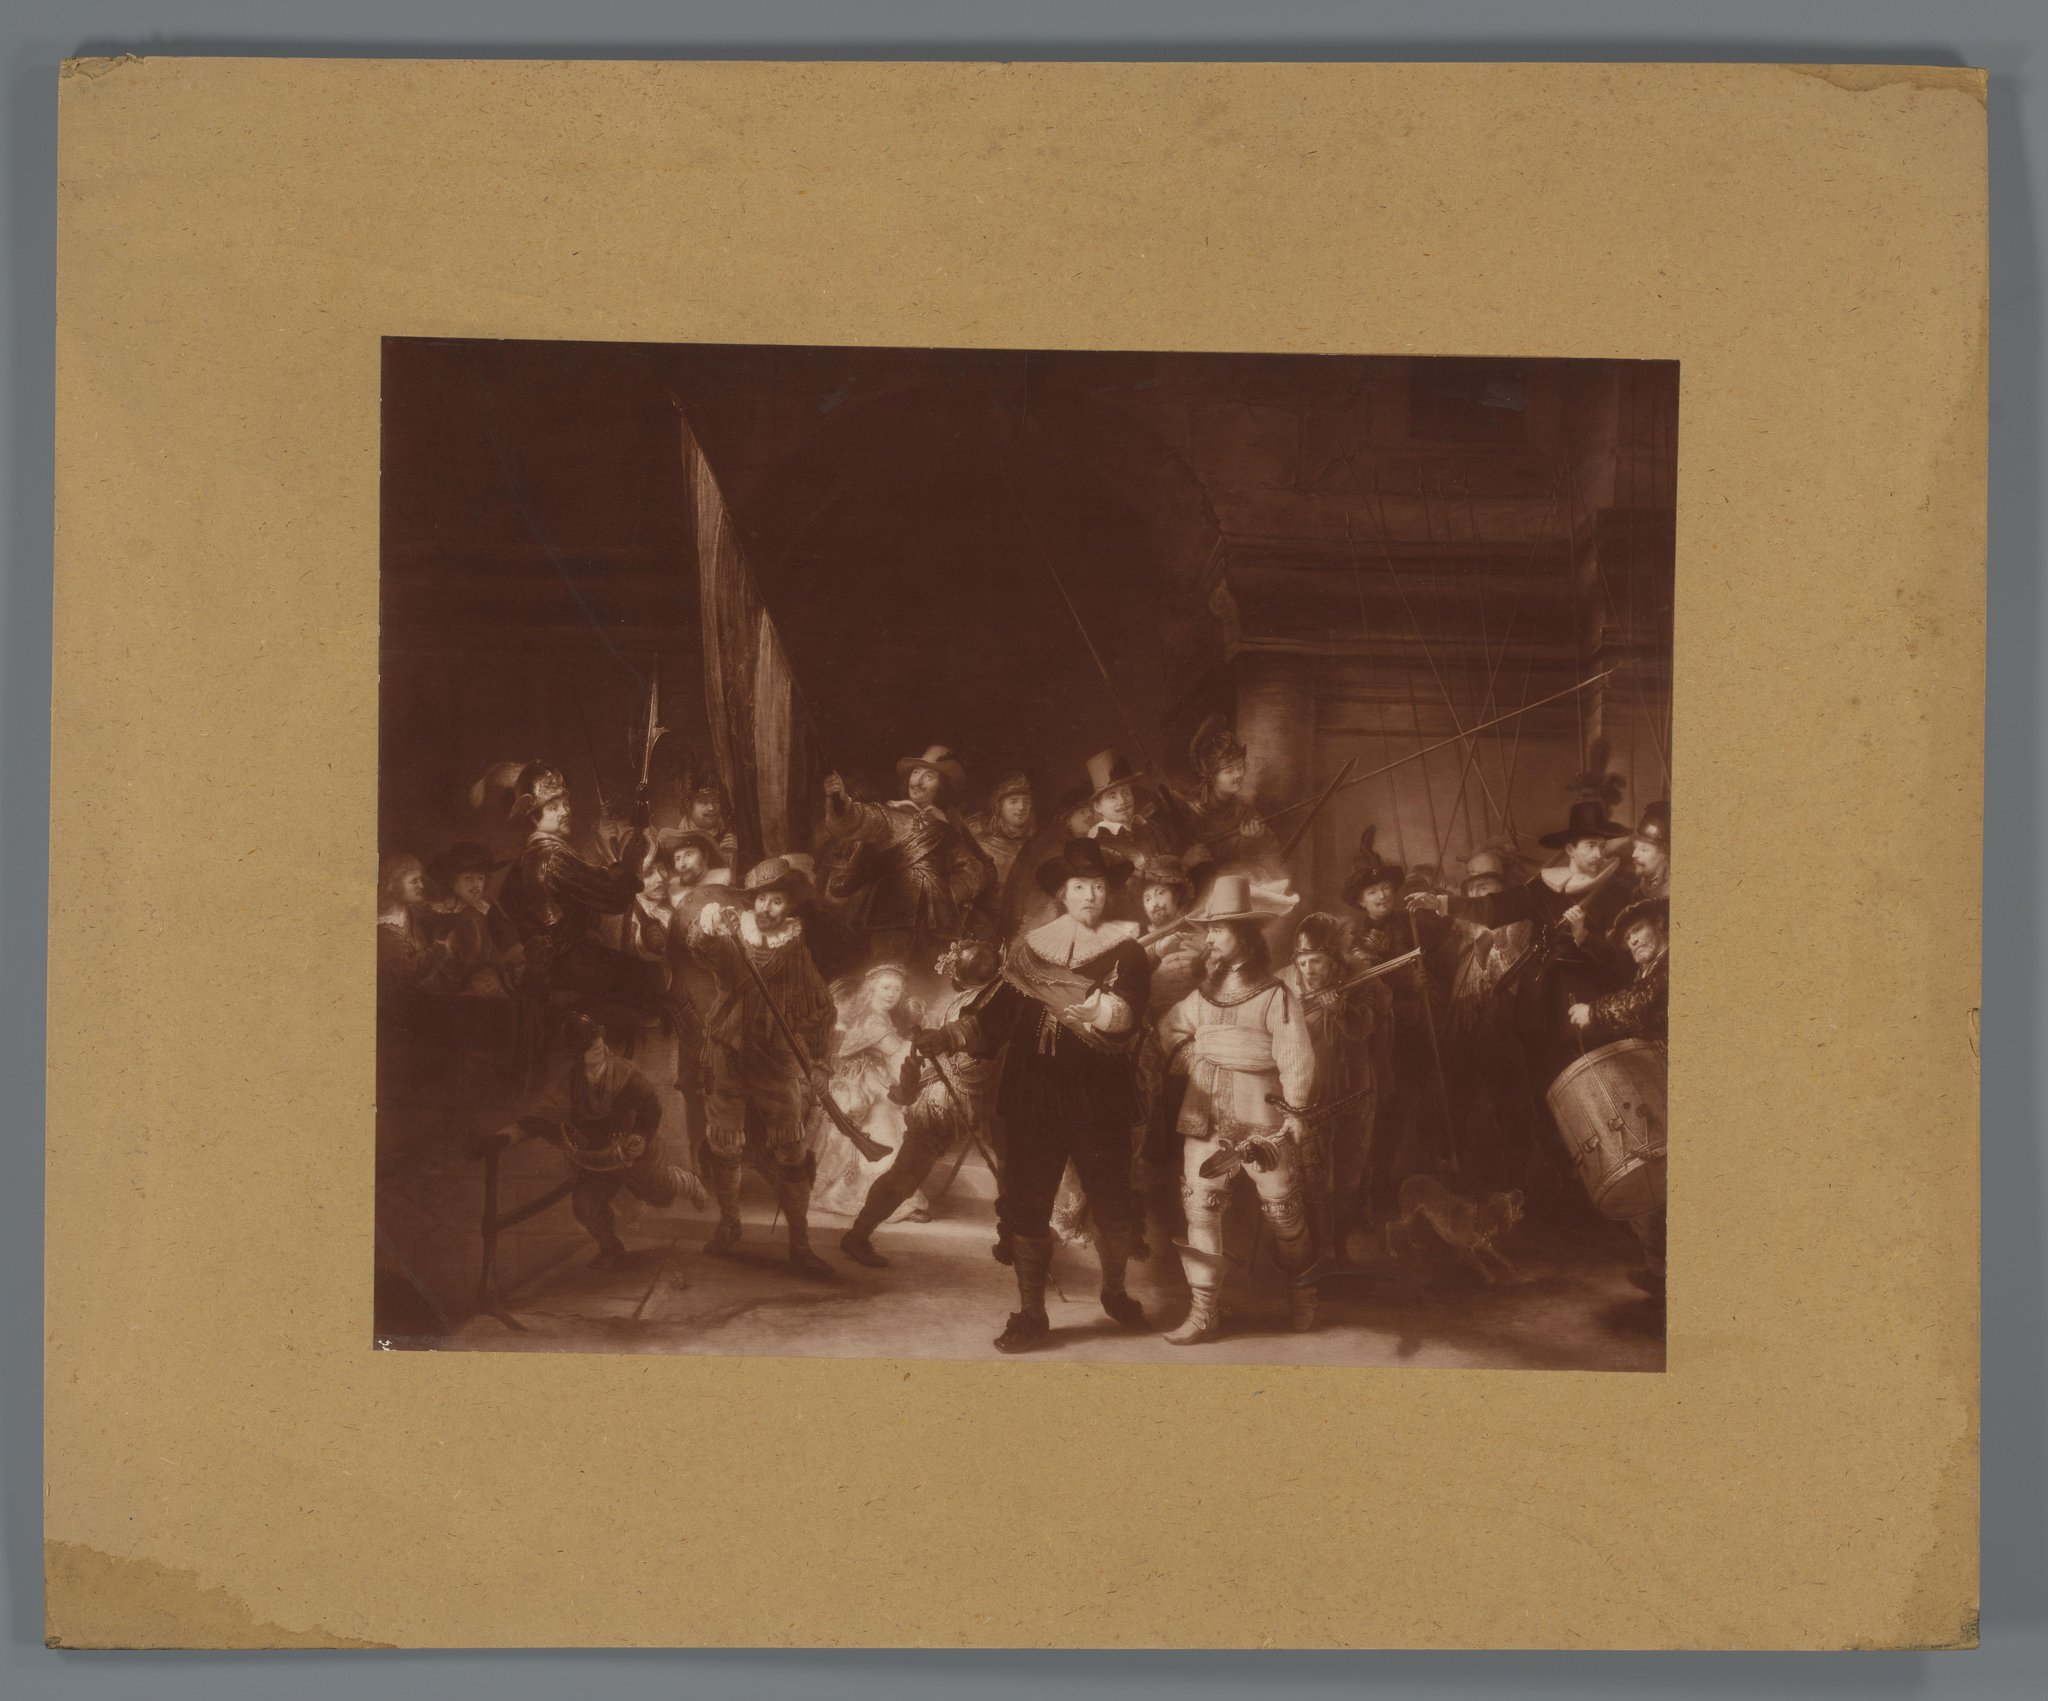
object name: photograph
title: Fotoreproductie van de kopie naar De Nachtwacht door Gerrit Lundends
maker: Anonymous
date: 1864-1930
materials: cardboard, paper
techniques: carbon print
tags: mayor, frans banninck cocq, warfare; military affairs (+ citizen soldiery, civil guard, citizen militia), picture, painting, land forces (+ citizen soldiery, civil guard, citizen militia), amsterdam